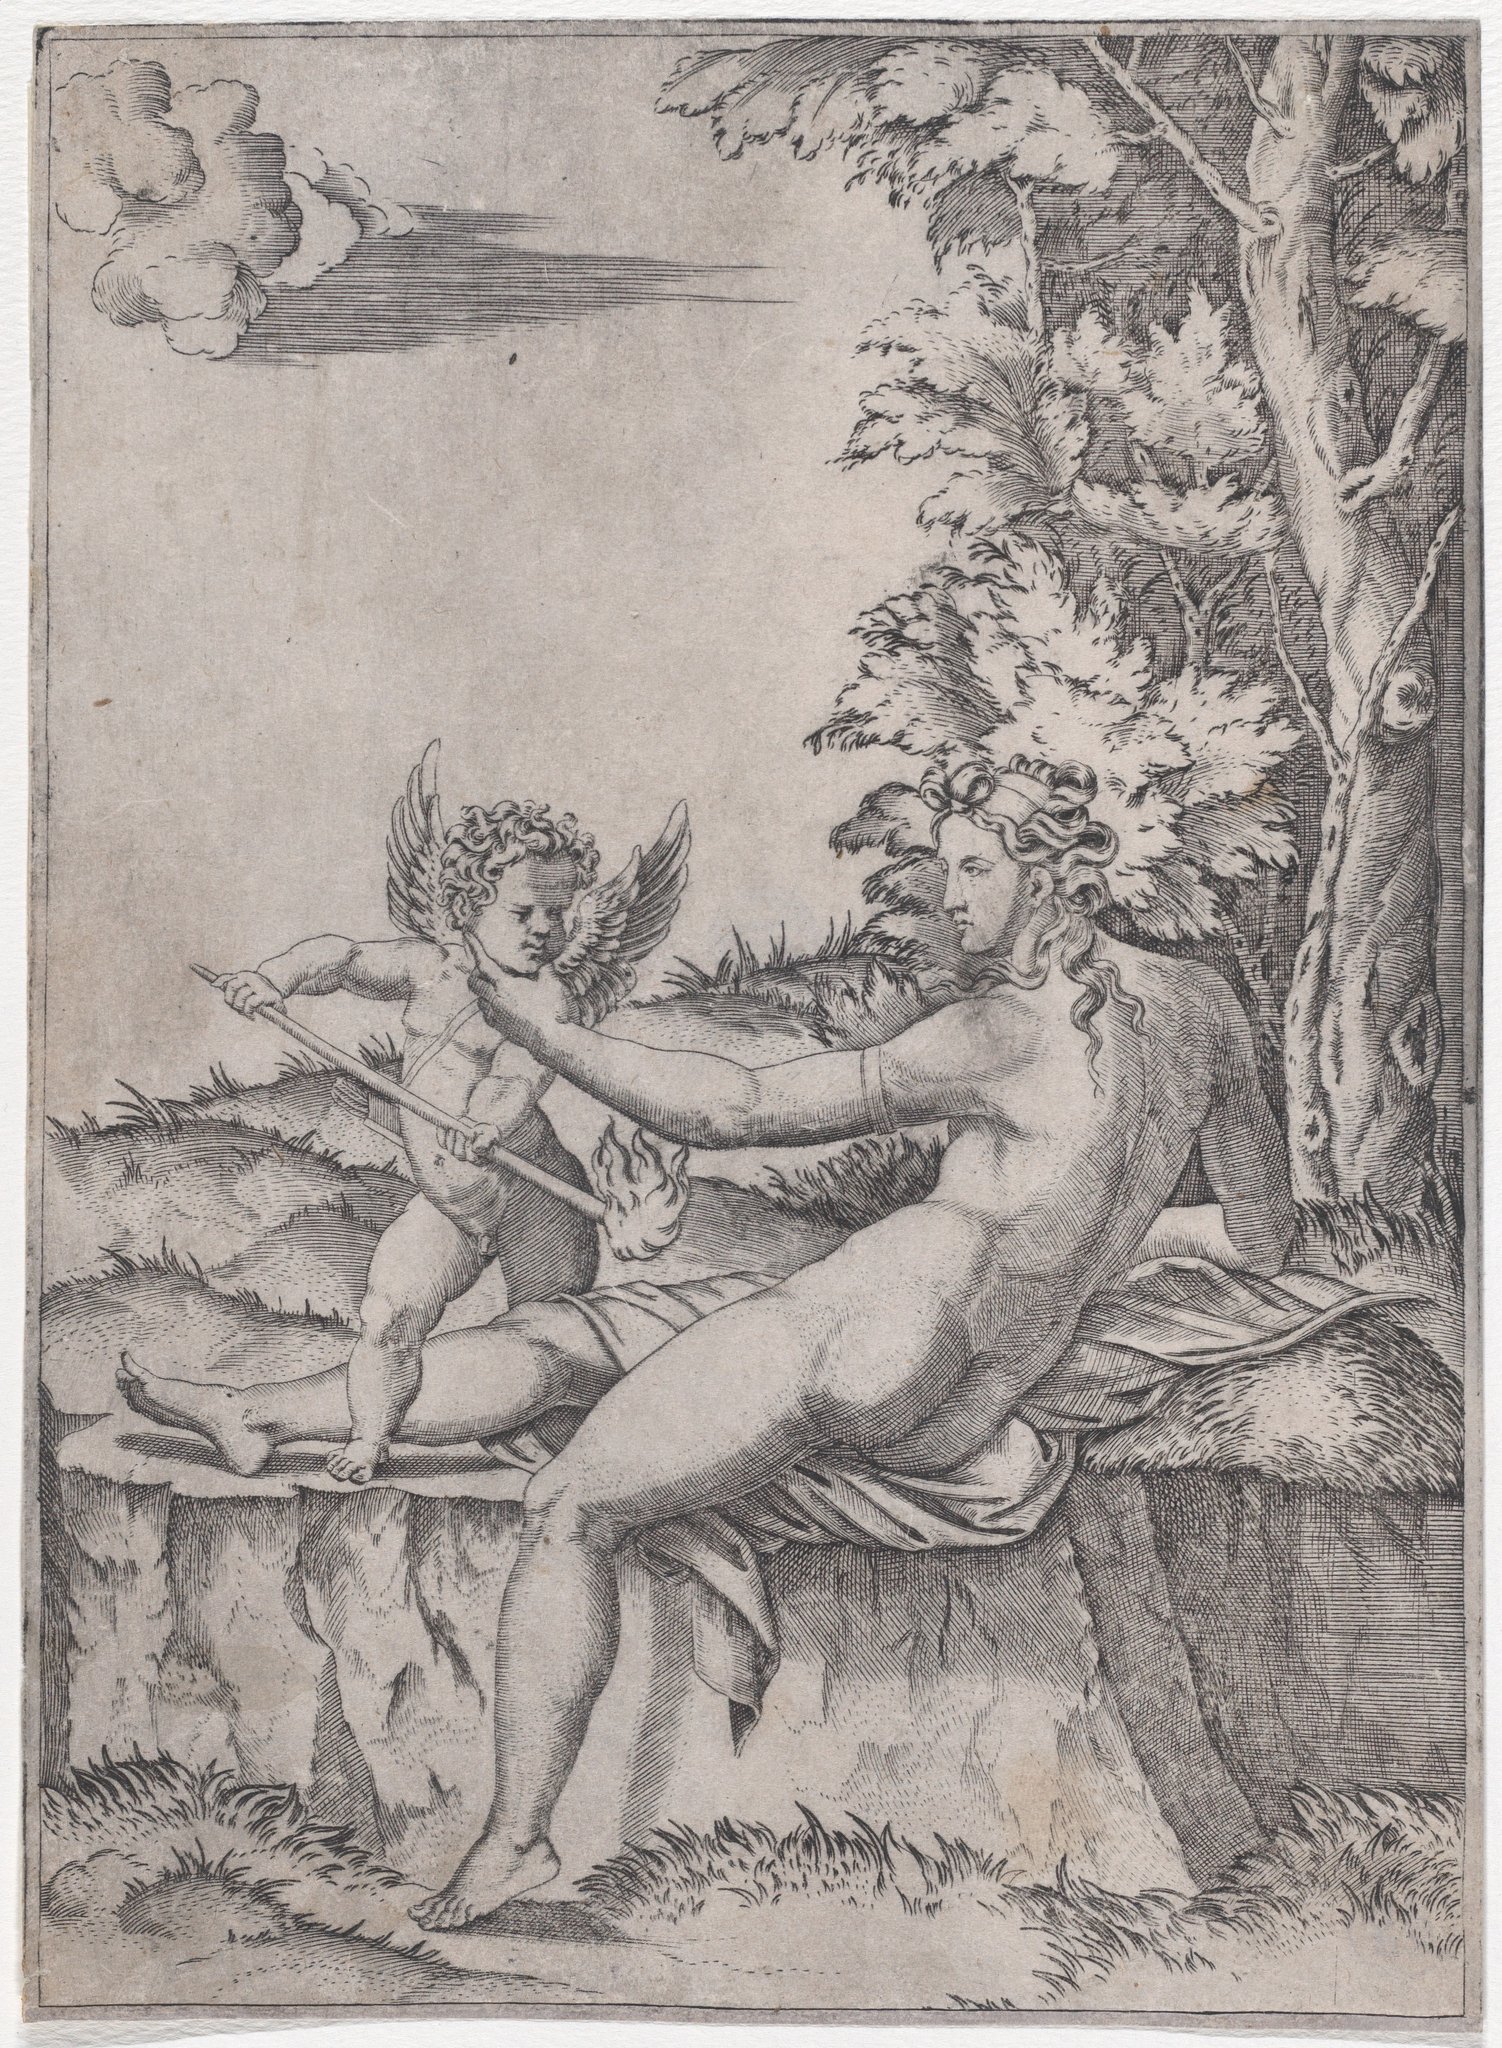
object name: print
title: Venus and Eros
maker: agostino veneziano (agostino dei musi)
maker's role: artist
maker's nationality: italian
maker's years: 1490-1536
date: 1514-1536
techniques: engraving